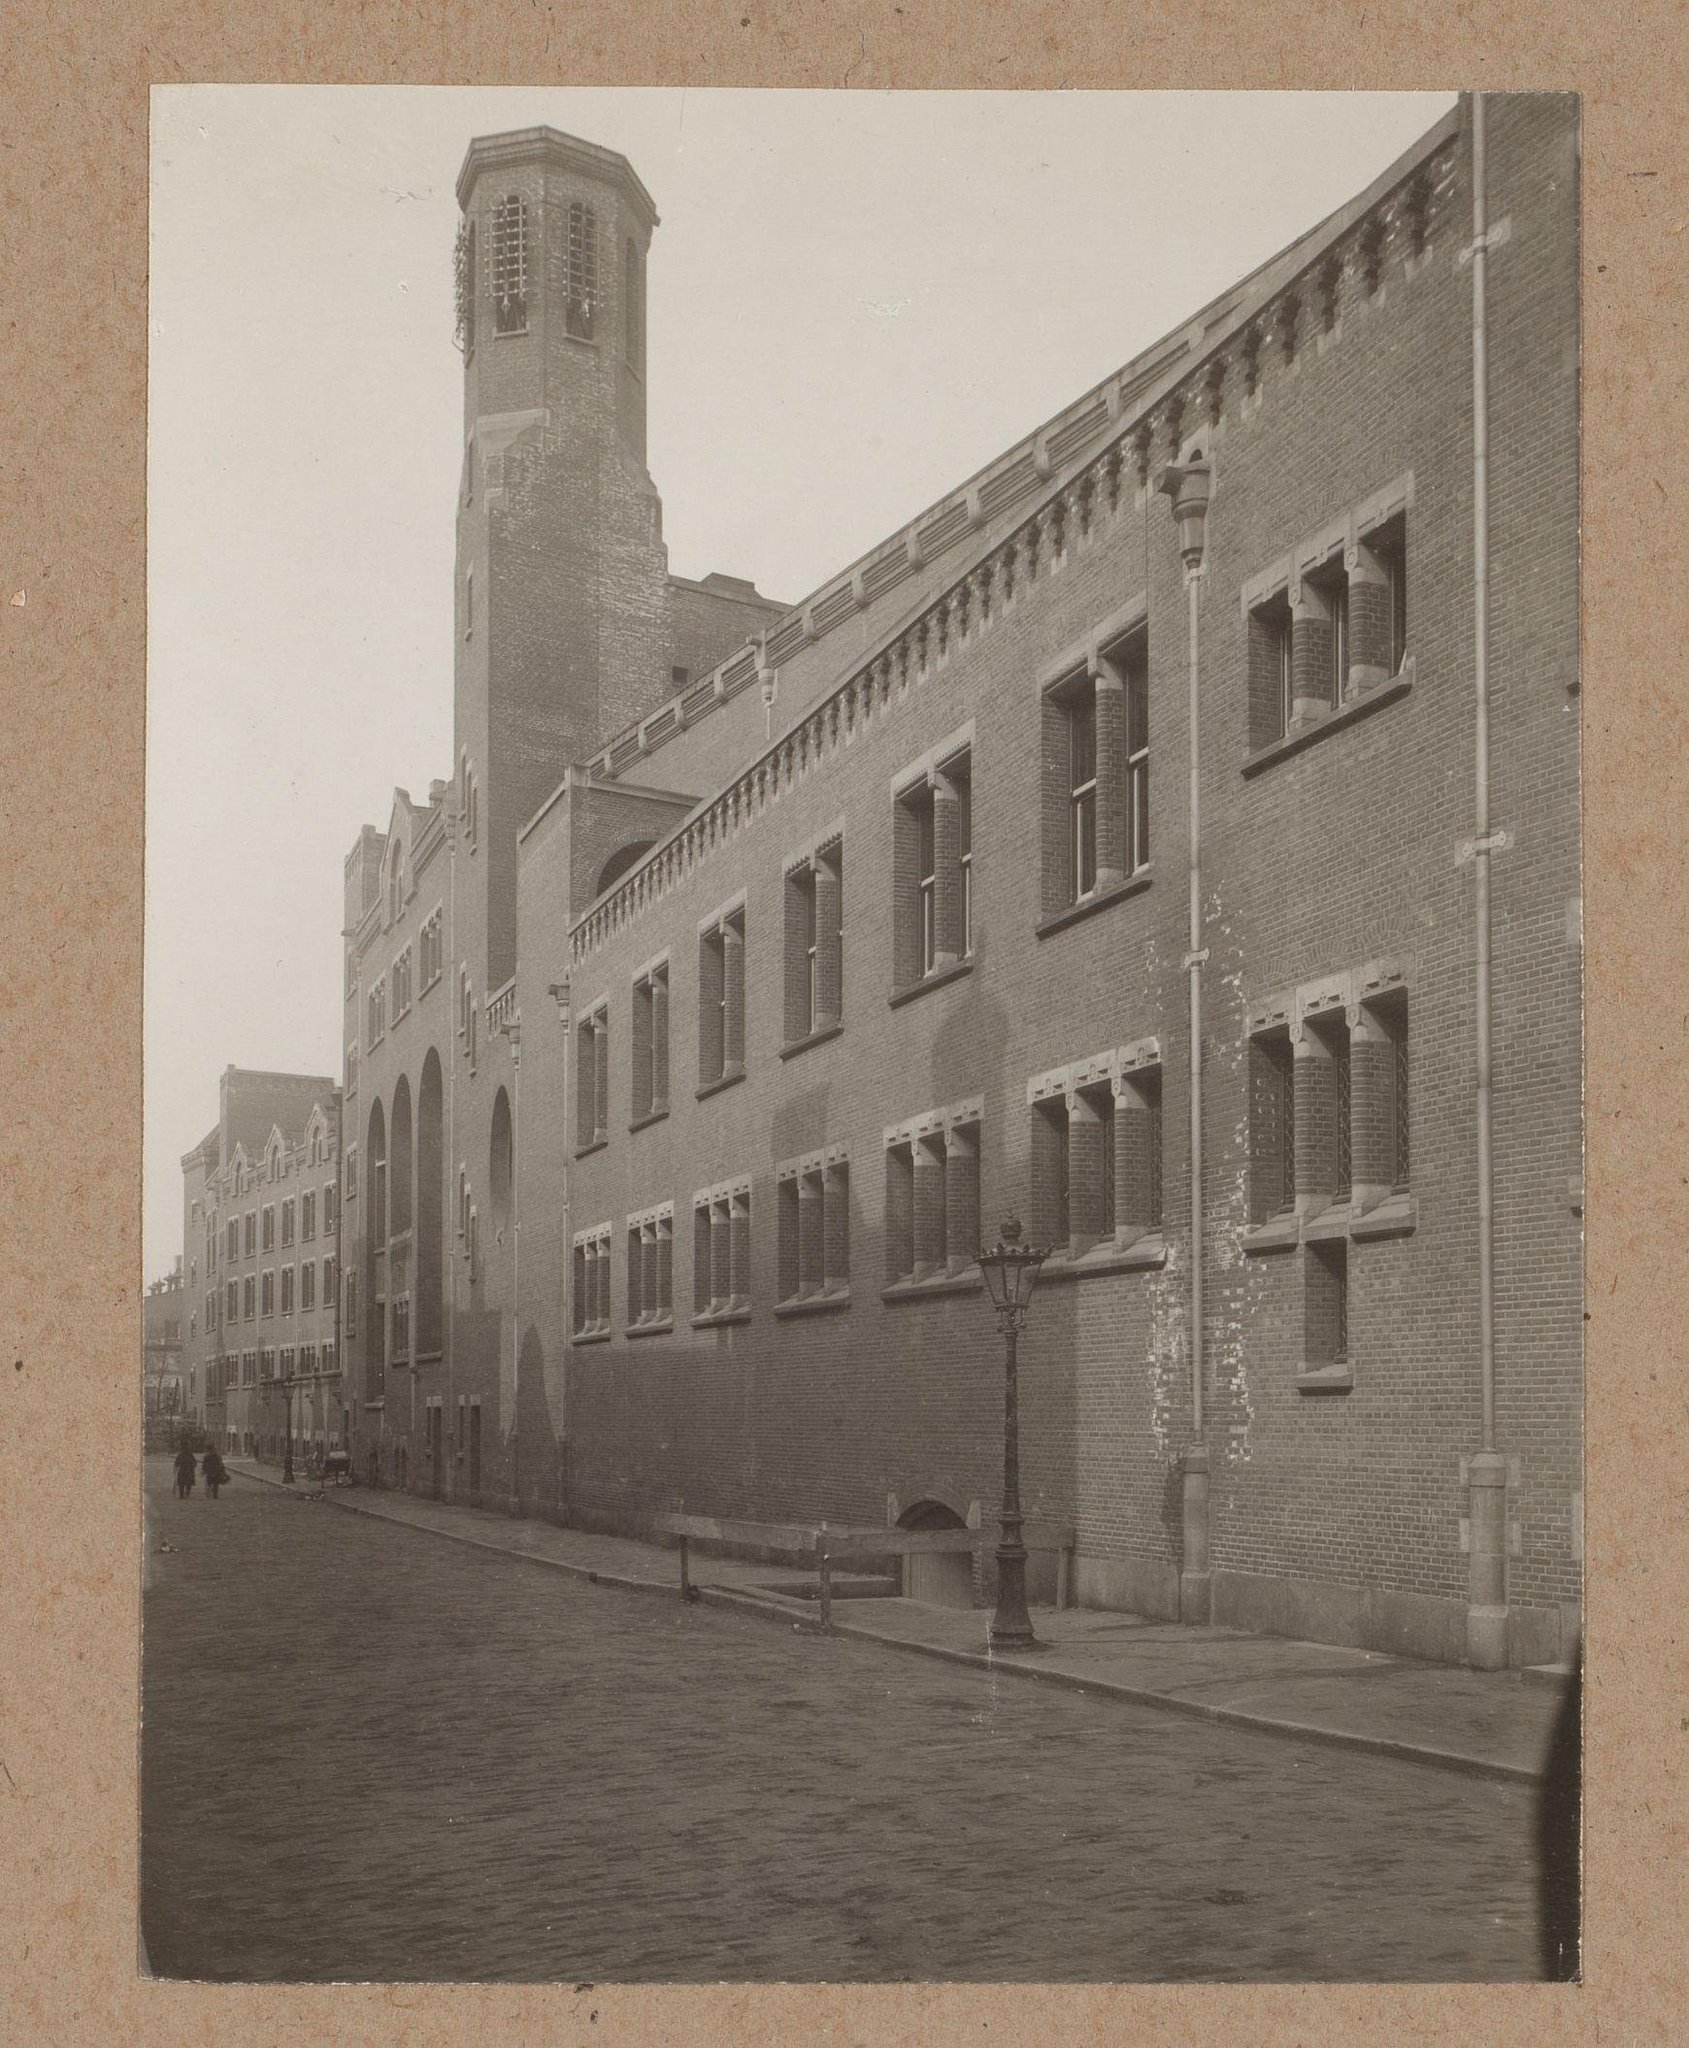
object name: photograph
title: Gevel aan de Beursstraat van de Beurs van Berlage te Amsterdam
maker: Anonymous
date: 1903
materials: paper, cardboard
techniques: gelatin silver print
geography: amsterdam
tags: stock exchange, stock-market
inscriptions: number: ‘2 a b’